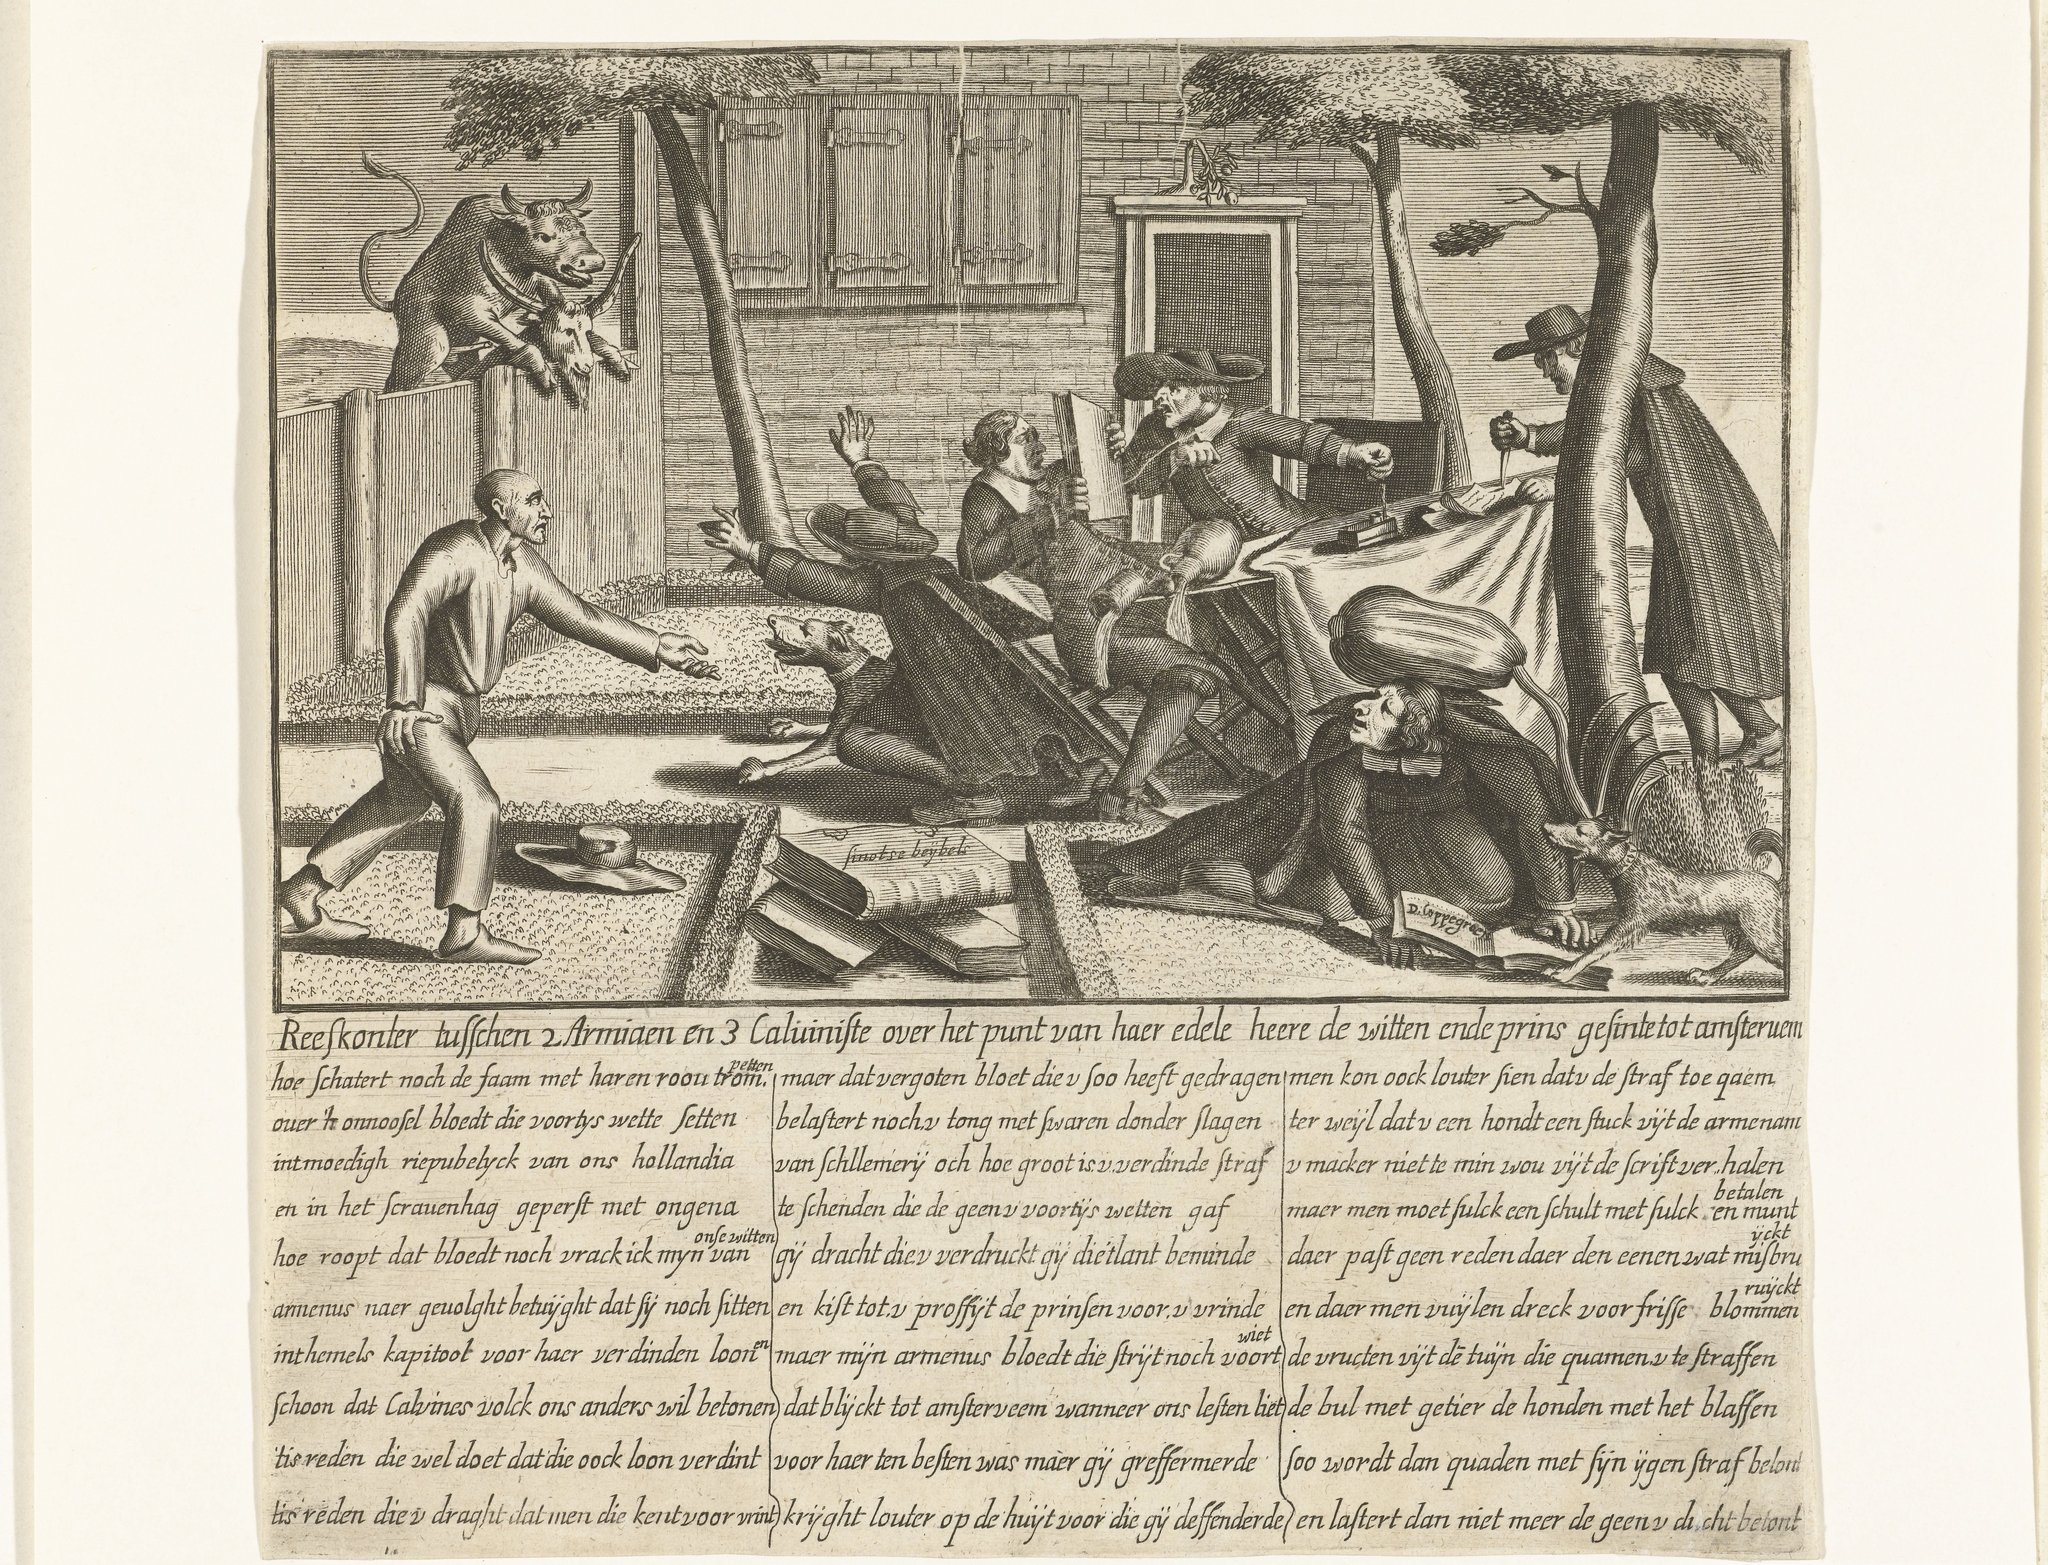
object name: cartoon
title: Spotprent op de strijd tussen arminianen en calvinisten over de geboeders De Witt en de prinsgezinden, ca. 1758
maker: Anonymous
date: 1756-1759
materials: paper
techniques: engraving, etching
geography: northern netherlands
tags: dordrecht, the hague, cornelis de witt, politician, johan de witt, william iii (prince of orange and king of england, scotland, and ireland), animals (+ animals mating), quarrel, argument, fighting, amsterdam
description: Spotprent op de strijd tussen arminianen en calvinisten over de geboeders De Witt en de prinsgezinden te Amsterdam, waarschijnlijk ca. 1758. Arminianen en calvinisten gaan rond een tafel in een tuin met elkaar op de vuist, reden zijn de afwijkende meningen over de strijd tussen de gebroeders De Witt en de prins in 1672. Links wordt een toekijkende geit gedekt door een stier. Onder de prent een vers in 3 kolommen.